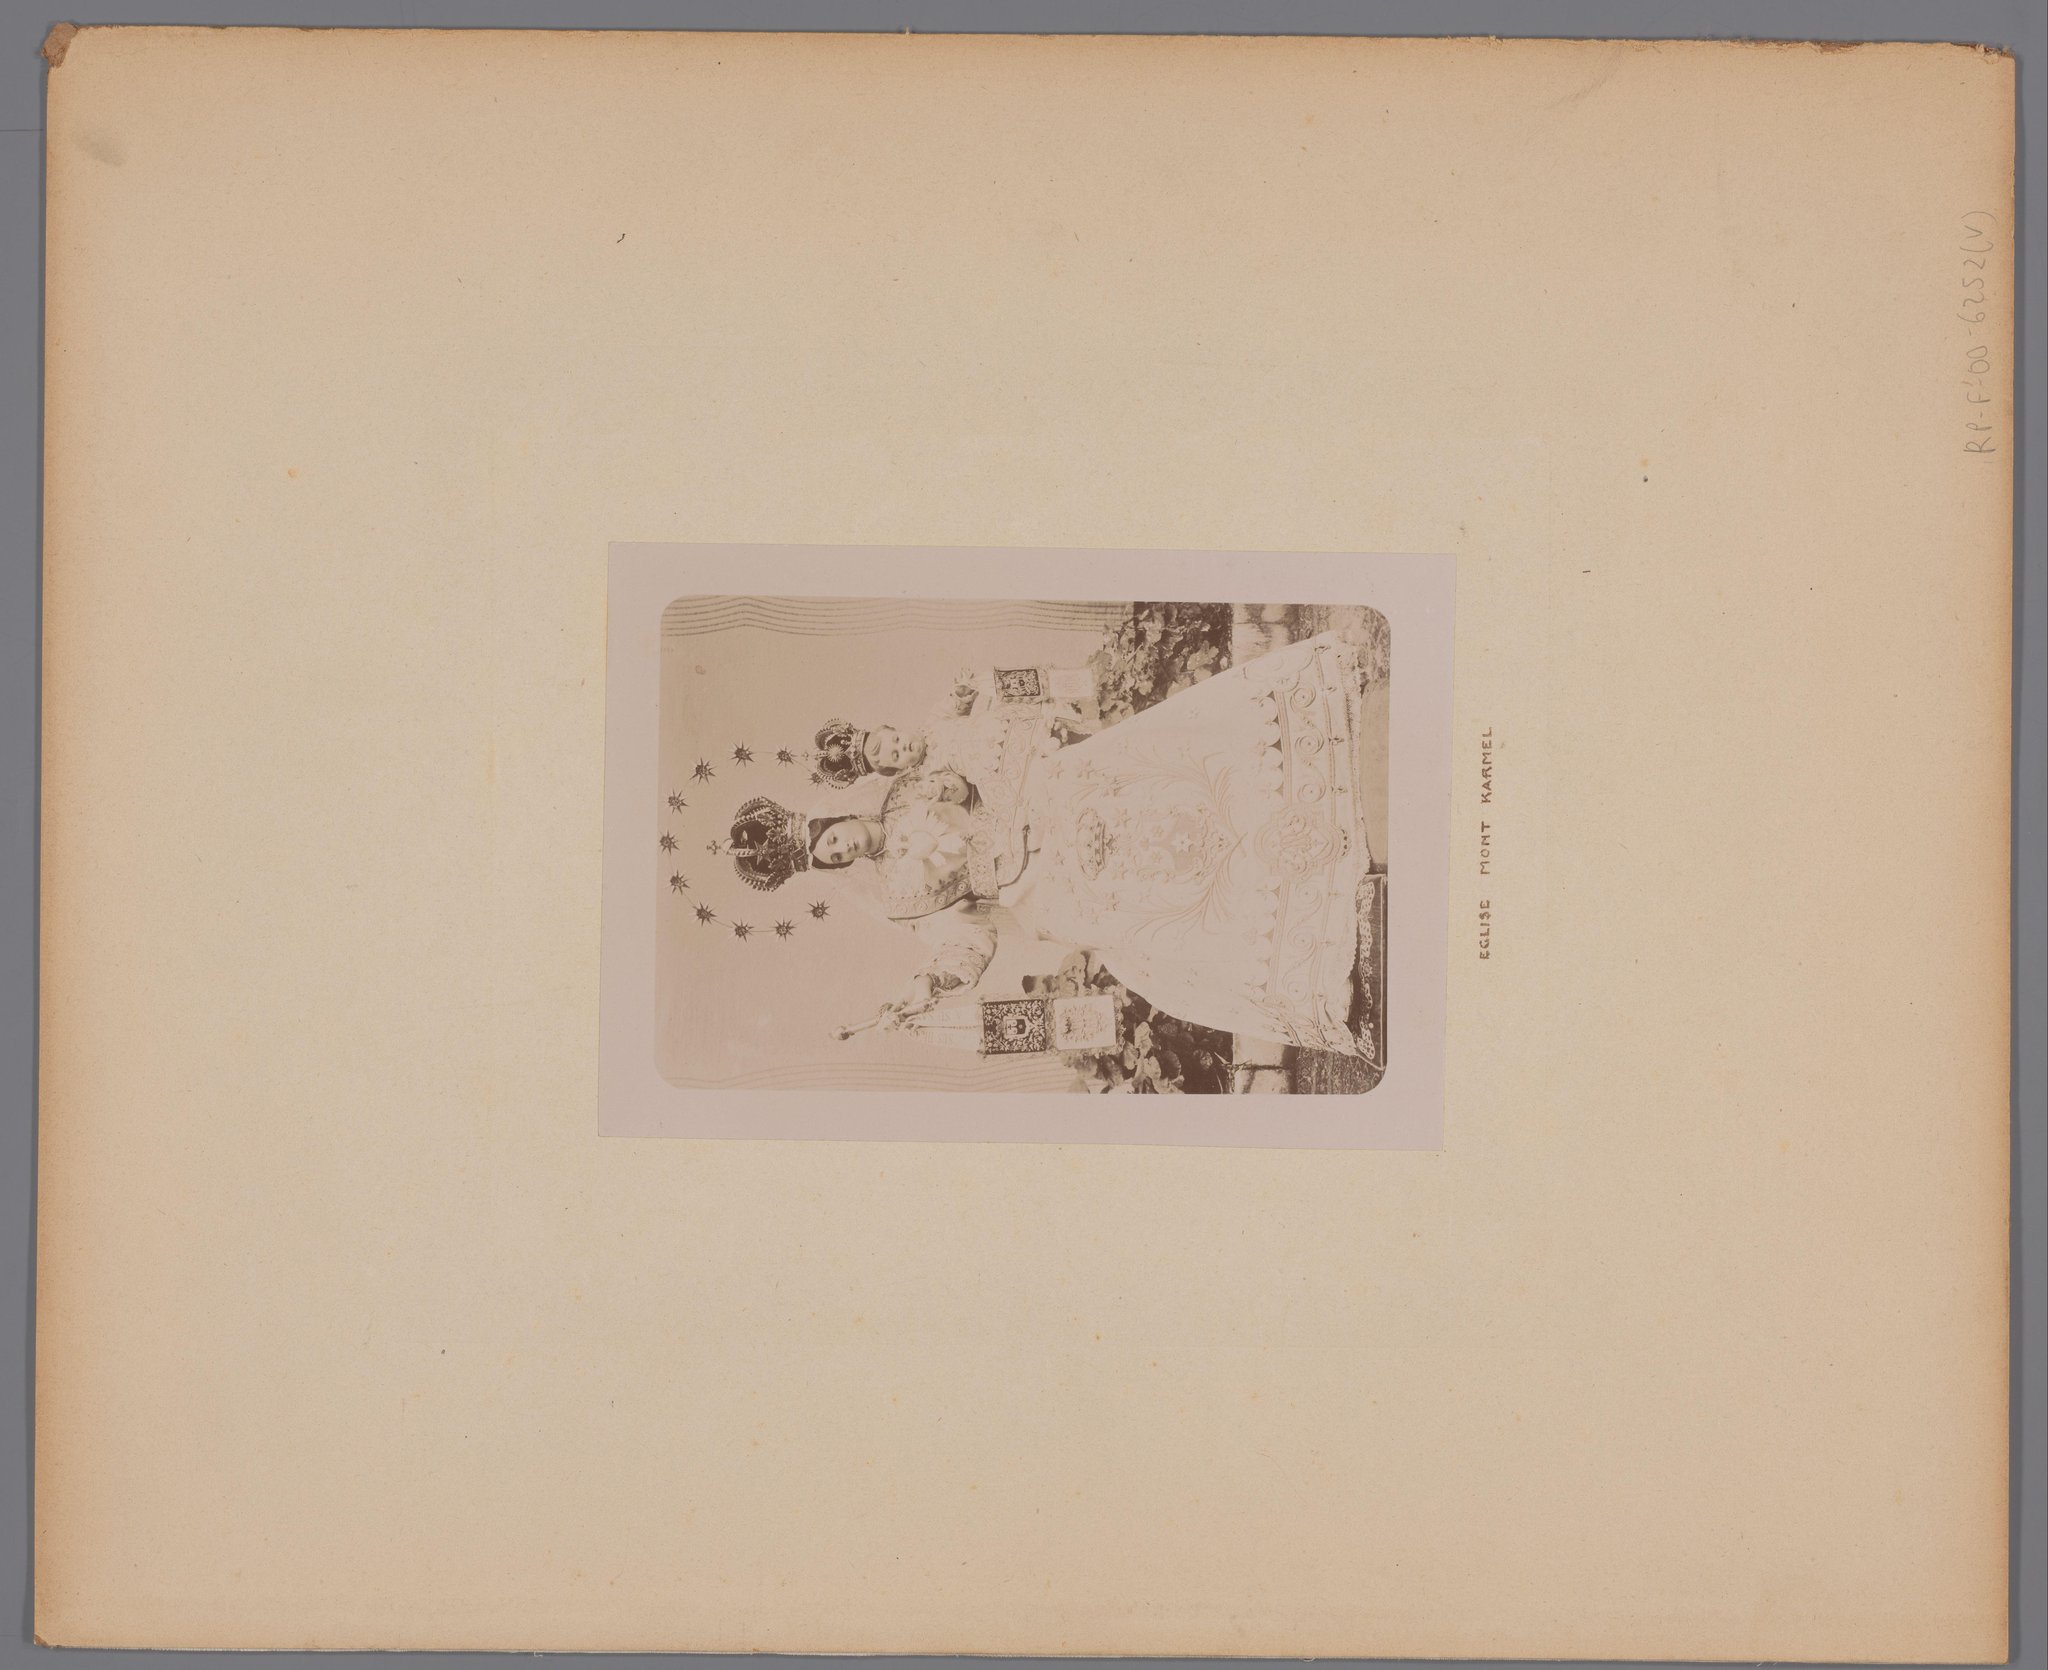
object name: photograph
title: Moeder Maria met kind, Kerk Mont Karmel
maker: Anonymous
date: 1870-1900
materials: cardboard, photographic support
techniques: albumen print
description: Voorstelling van moeder Maria met kind Chritus op de arm. Versierd met een grote halfronde boog om haar hoofd, en beiden dragen grote kronen.